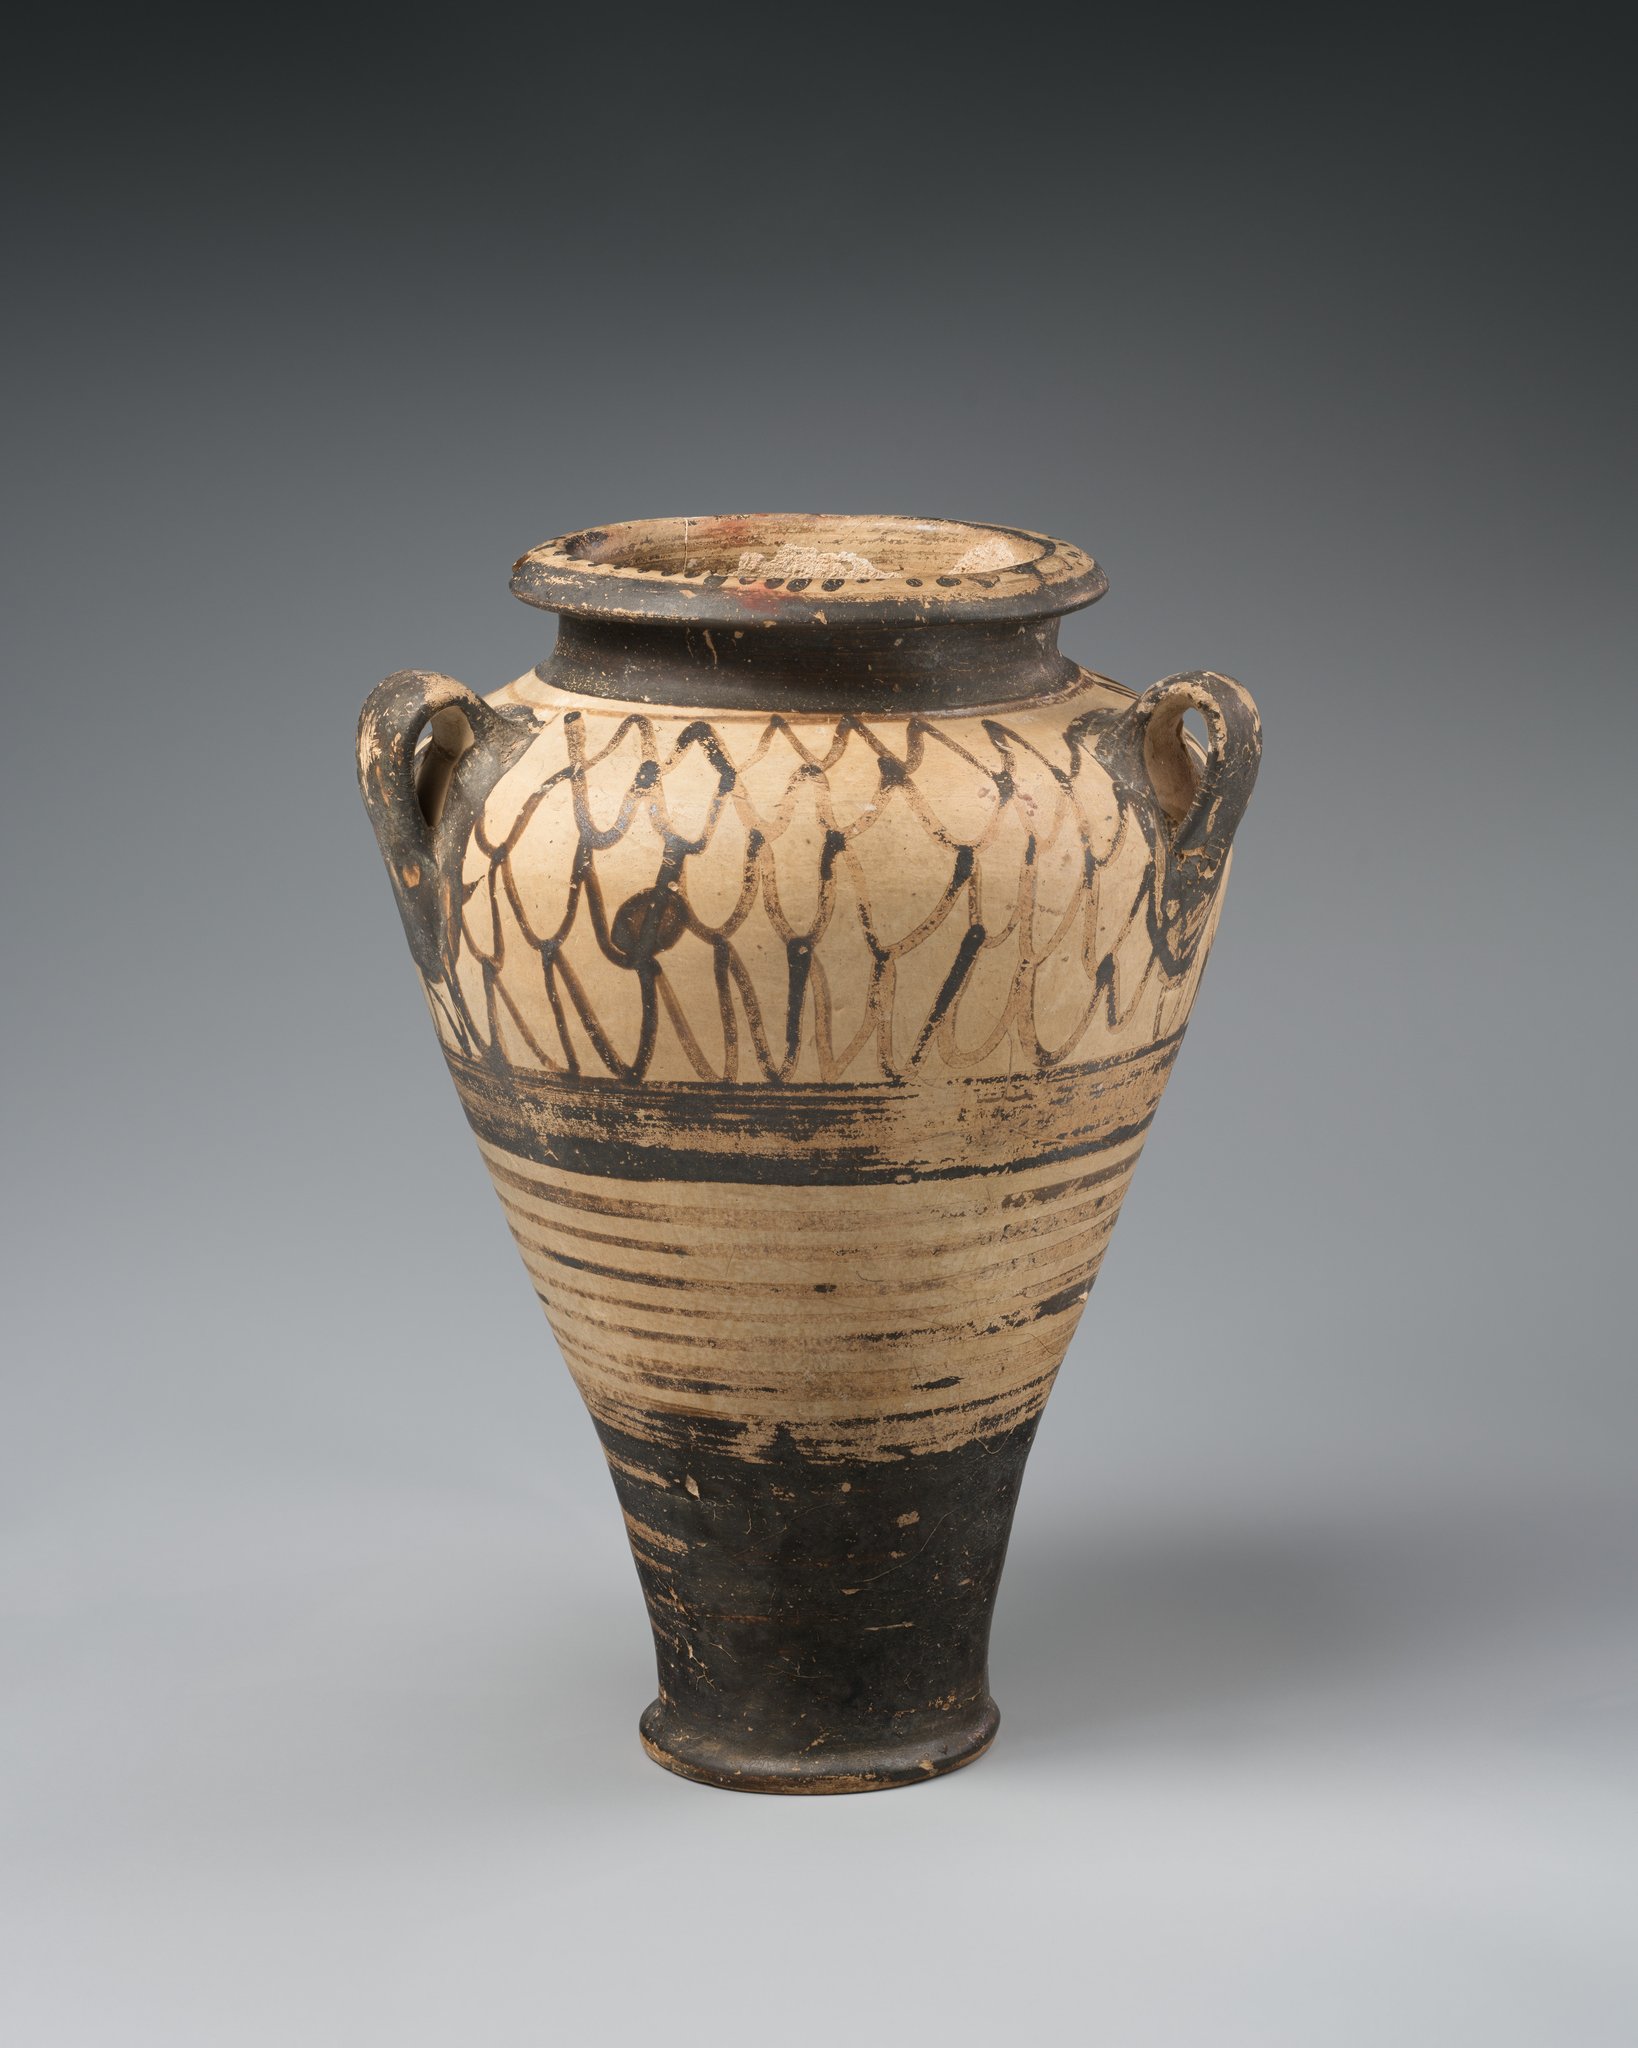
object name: pithoid jar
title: Terracotta pithoid jar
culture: mycenaean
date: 1300-1201 BCE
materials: terracotta